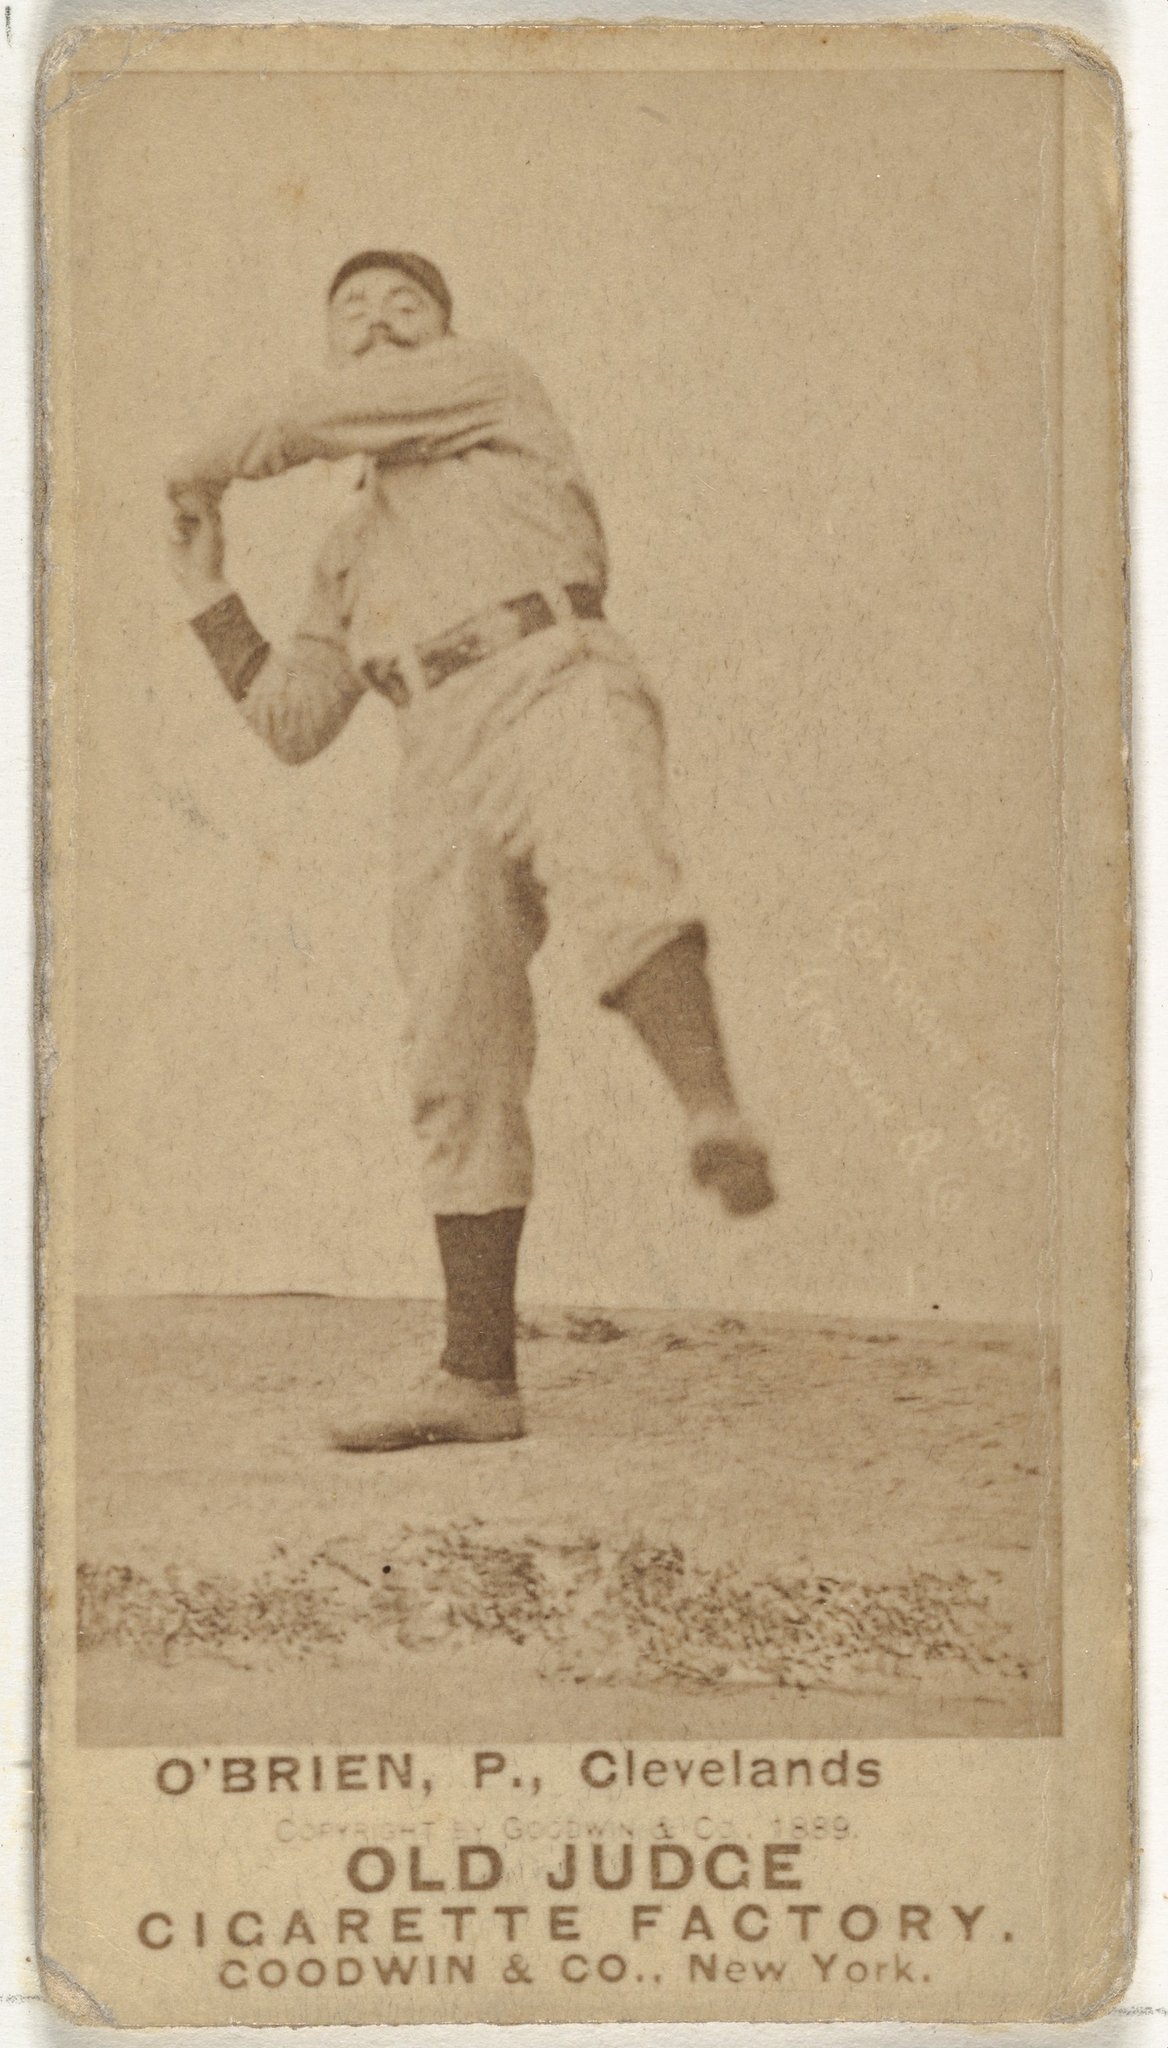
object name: baseball card, photograph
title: John F. "Cinders" O'Brien, Pitcher, Cleveland, from the Old Judge series (N172) for Old Judge Cigarettes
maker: goodwin & company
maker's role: publisher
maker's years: 1850-1950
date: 1889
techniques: albumen silver print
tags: men,portraits,baseball,athletes